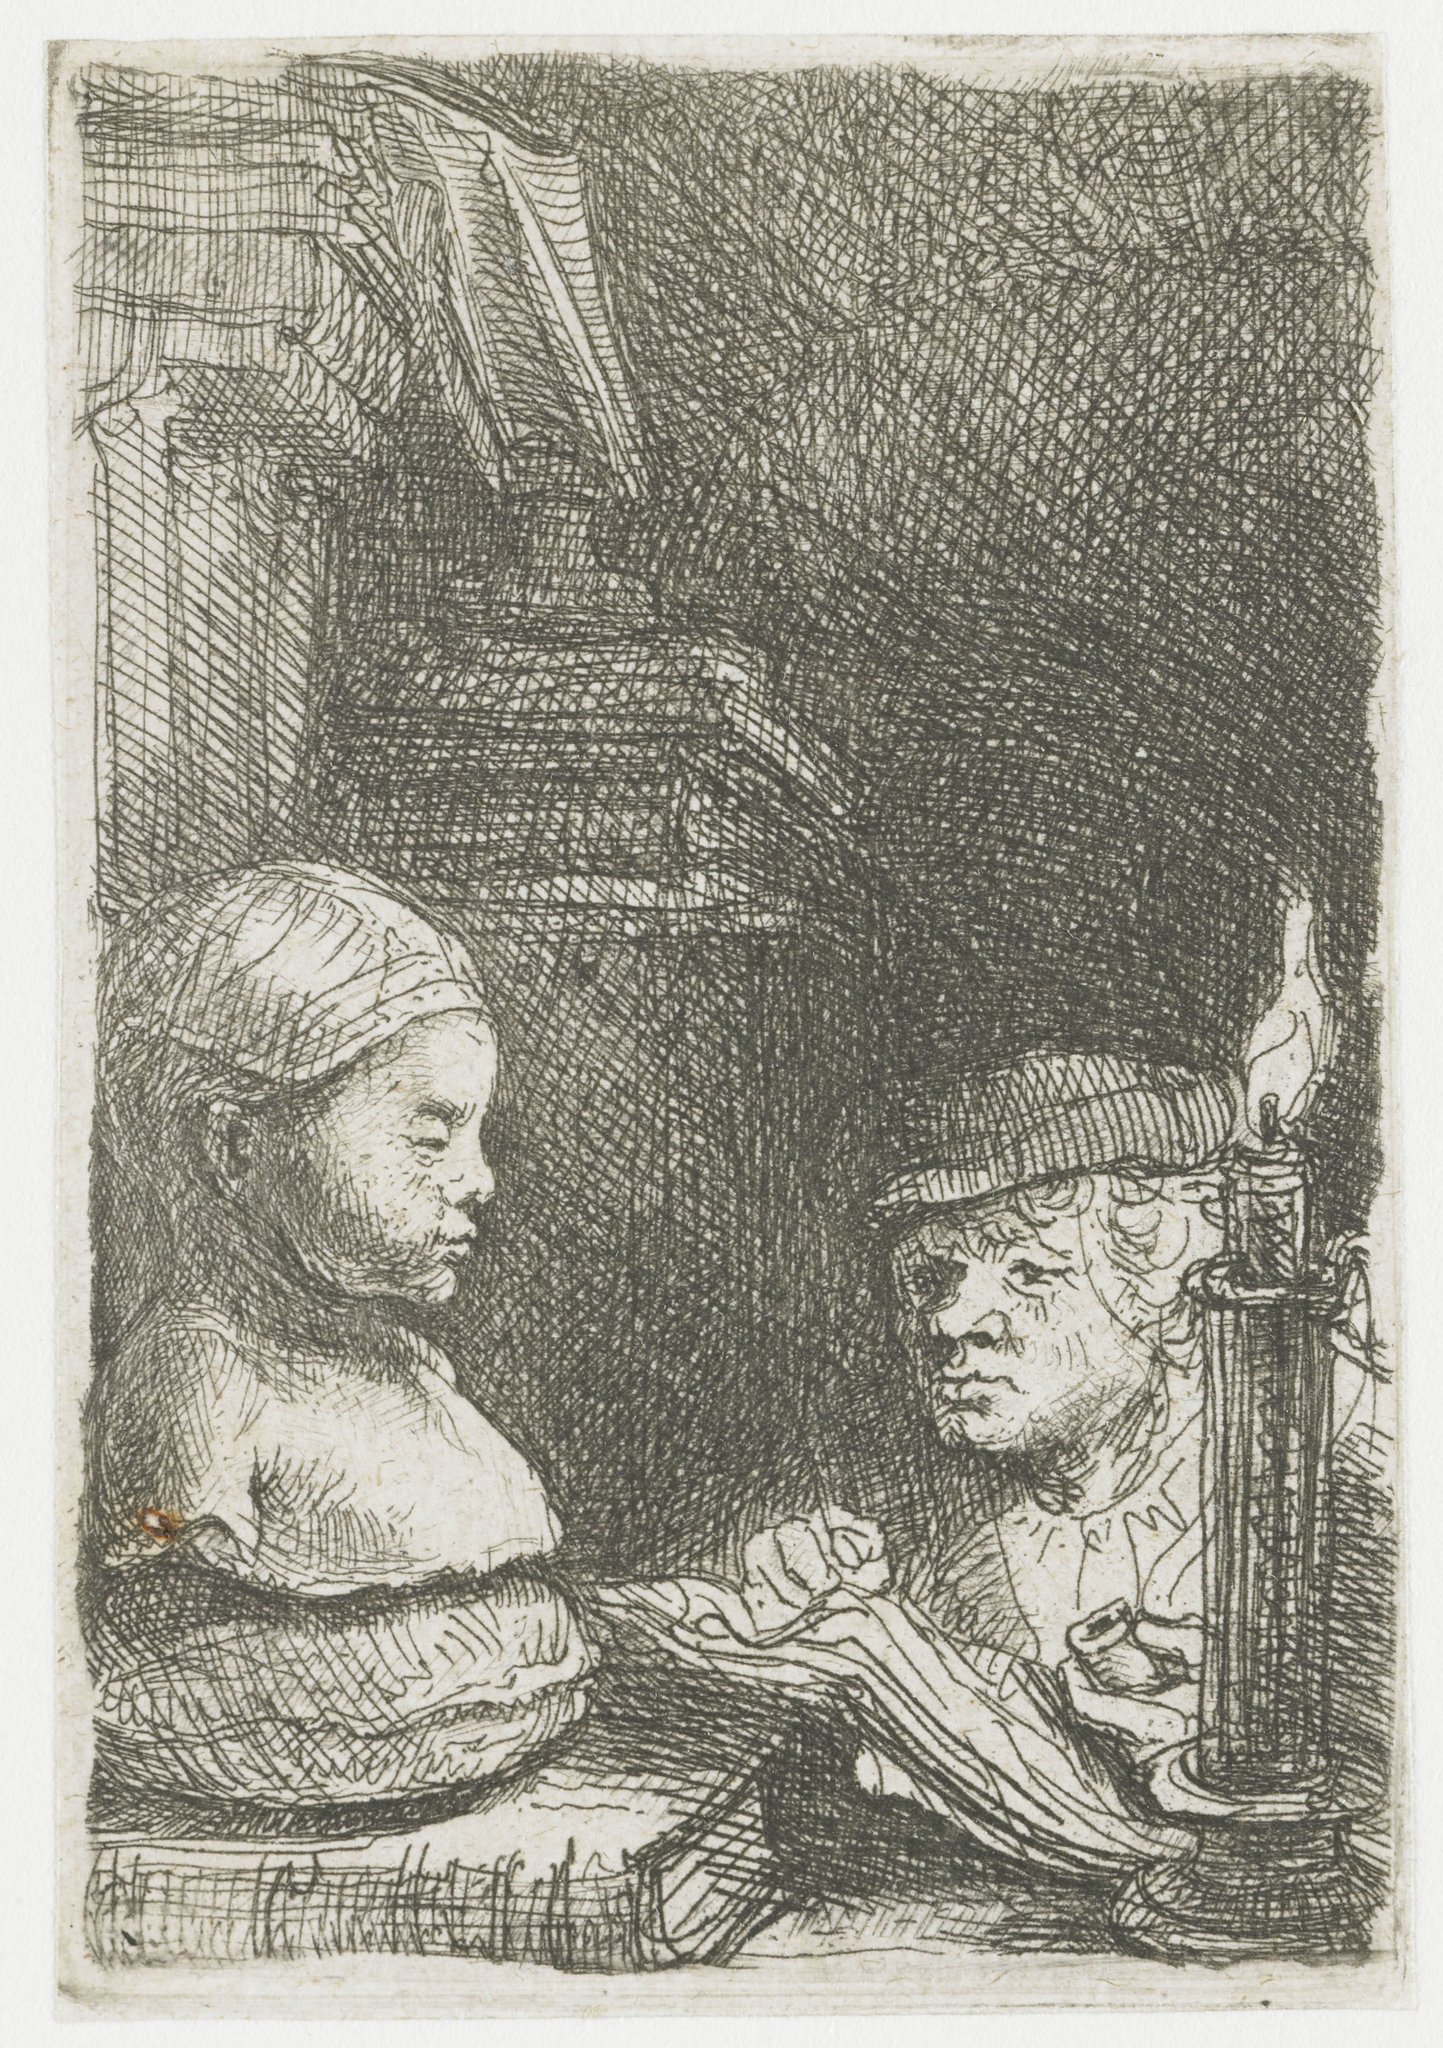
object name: print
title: Man drawing from a cast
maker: rembrandt van rijn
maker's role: draughtsman, painter, print maker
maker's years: 1606-1669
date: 1641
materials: paper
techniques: etching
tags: drawing, art (+ artist studying classical remains)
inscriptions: mark: Lugt 2228